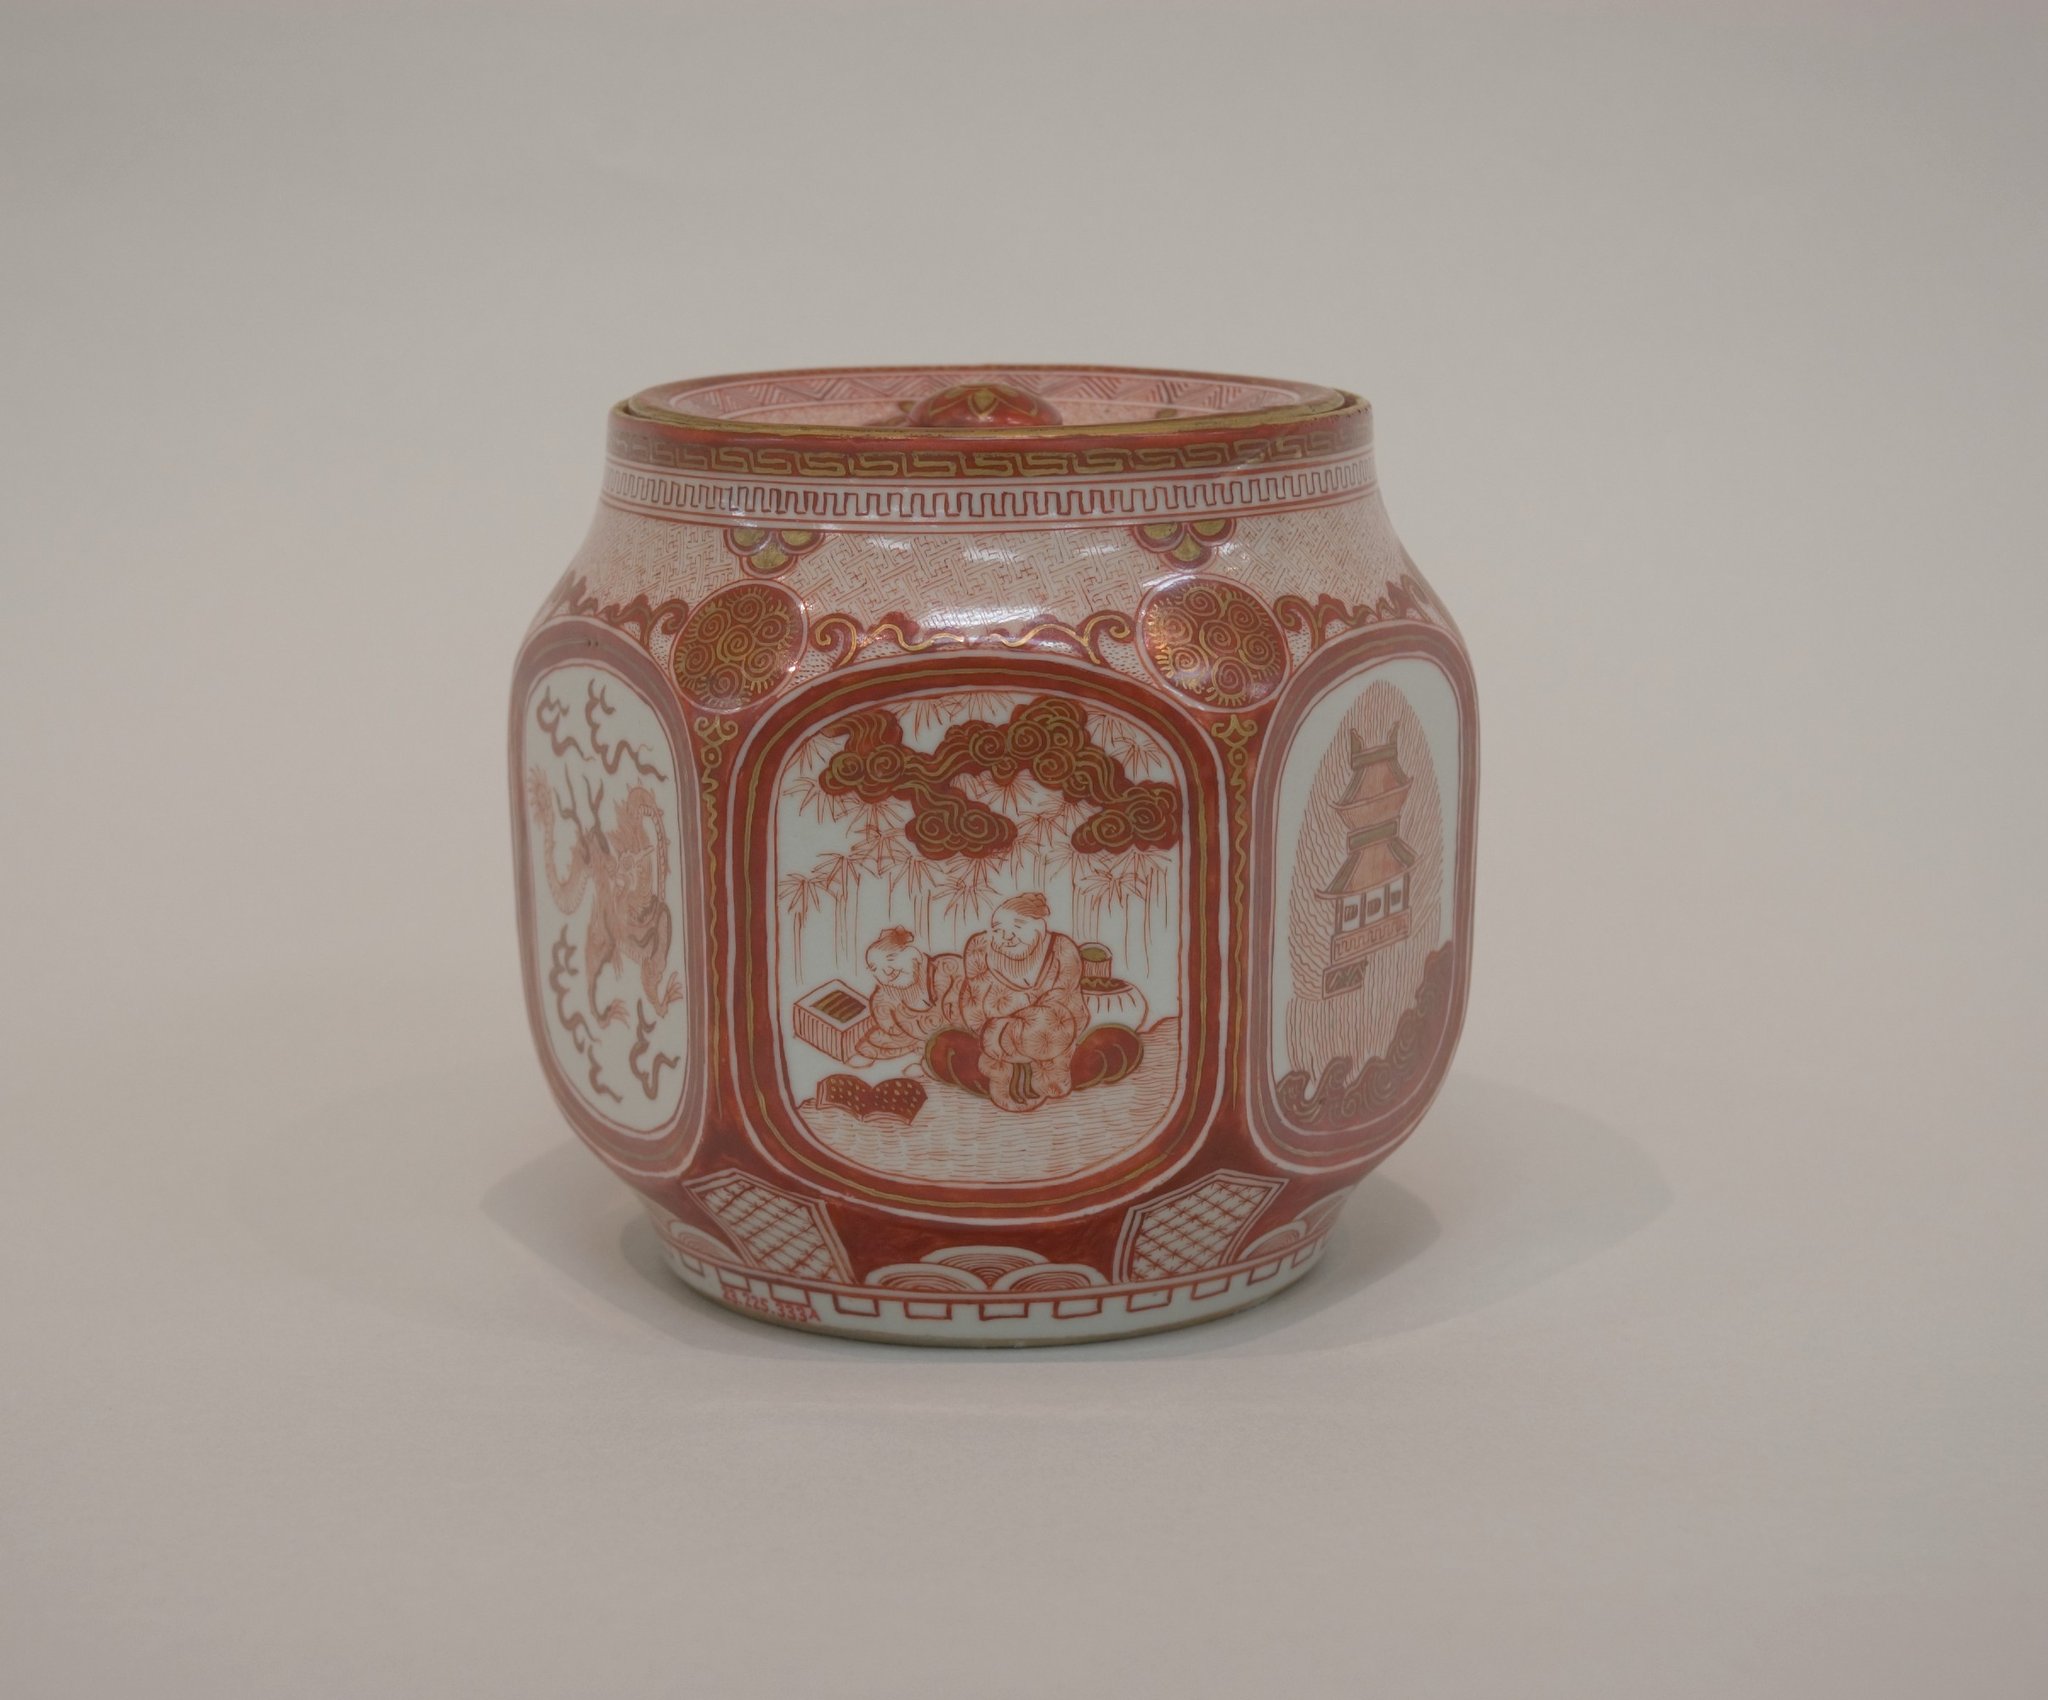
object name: jar with cover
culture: japanese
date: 1830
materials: gold, porcelain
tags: human figures